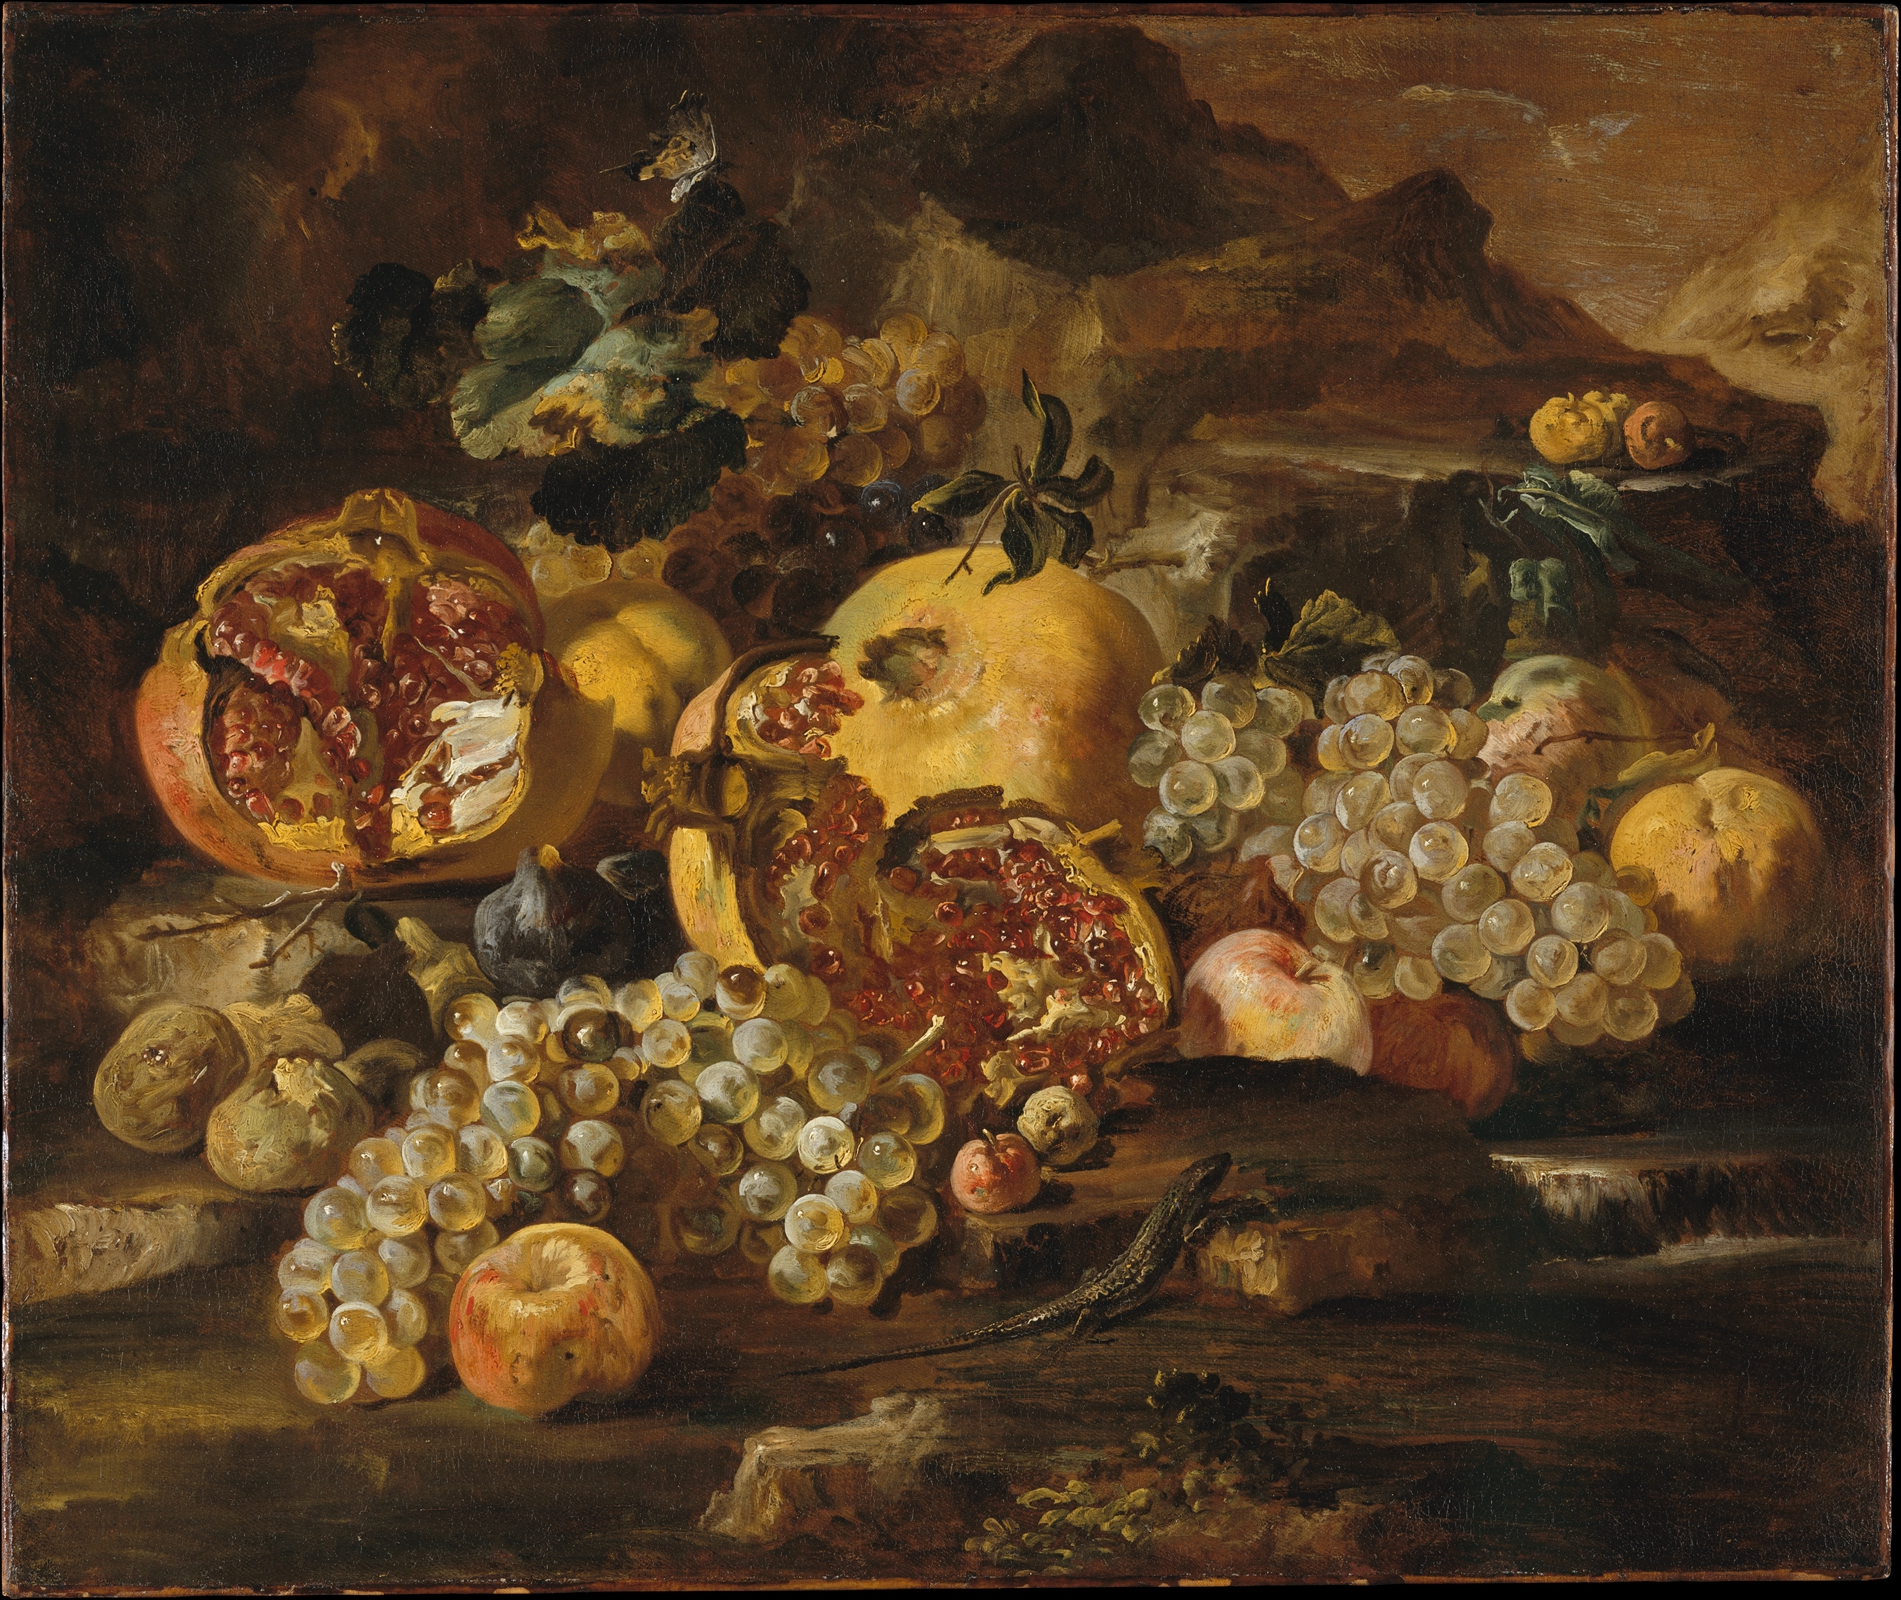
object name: painting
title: Pomegranates and Other Fruit in a Landscape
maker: abraham brueghel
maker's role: artist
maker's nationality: flemish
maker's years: 1631-1697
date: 1650-1674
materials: canvas, oil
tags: apples,grapes,pomegranates,lizards,still life